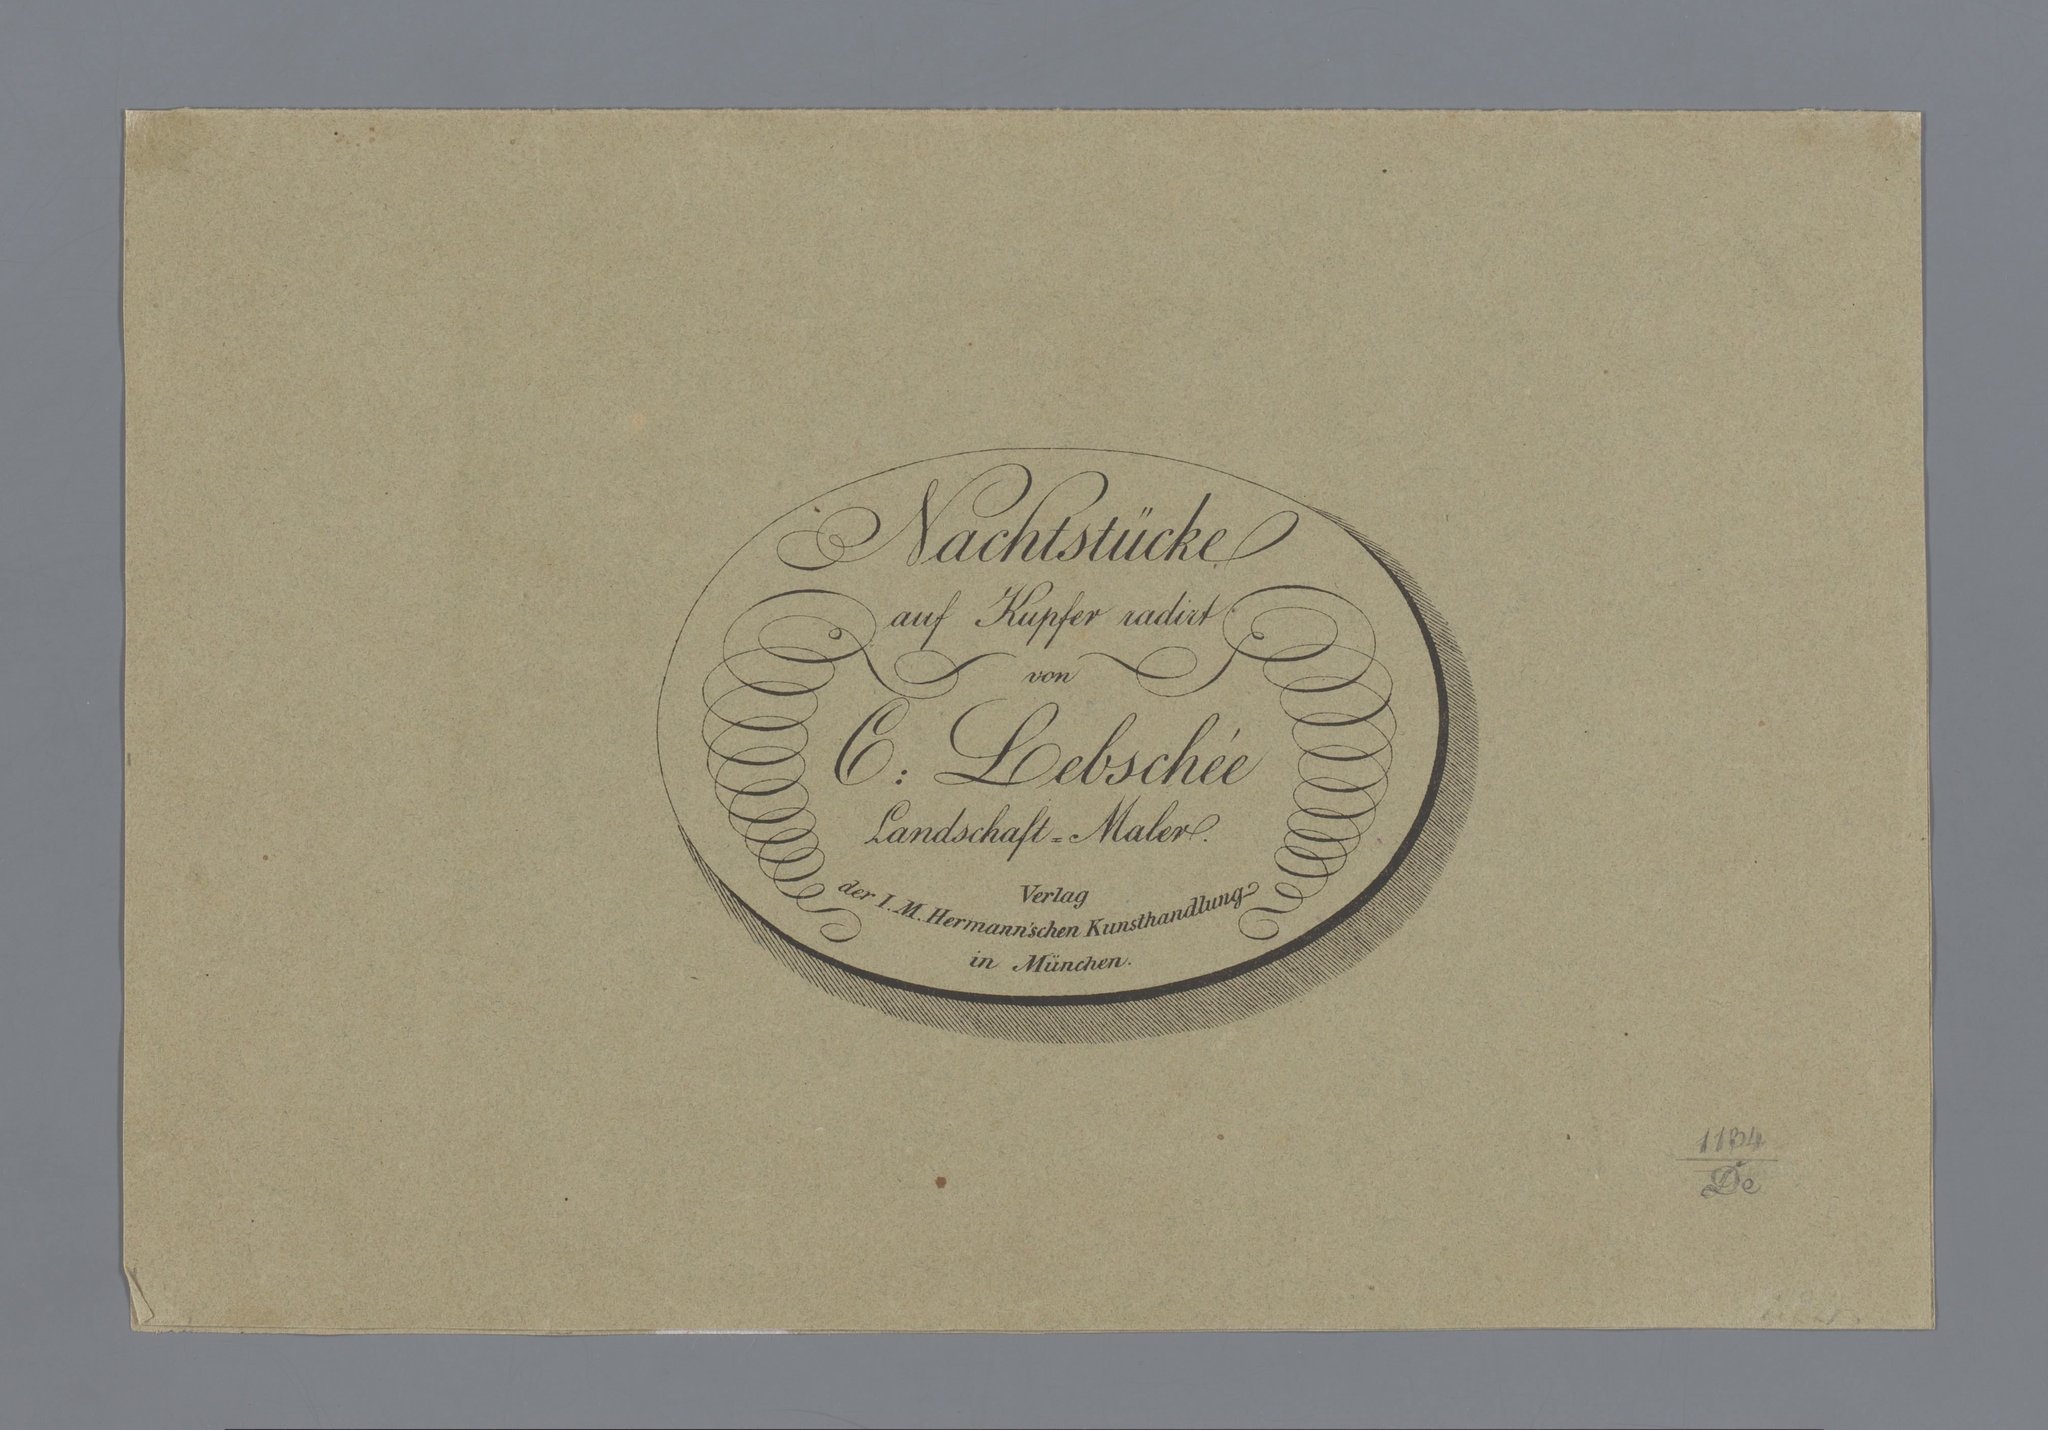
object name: wrapper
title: Omslag voor een serie van vijf prenten met landschappen bij nacht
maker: carl august lebschee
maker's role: draughtsman, painter, print maker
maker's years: 1800-1877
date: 1827-1828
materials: paper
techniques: etching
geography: munich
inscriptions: collector's mark: Lugt 2228, collector's mark: Lugt 2760